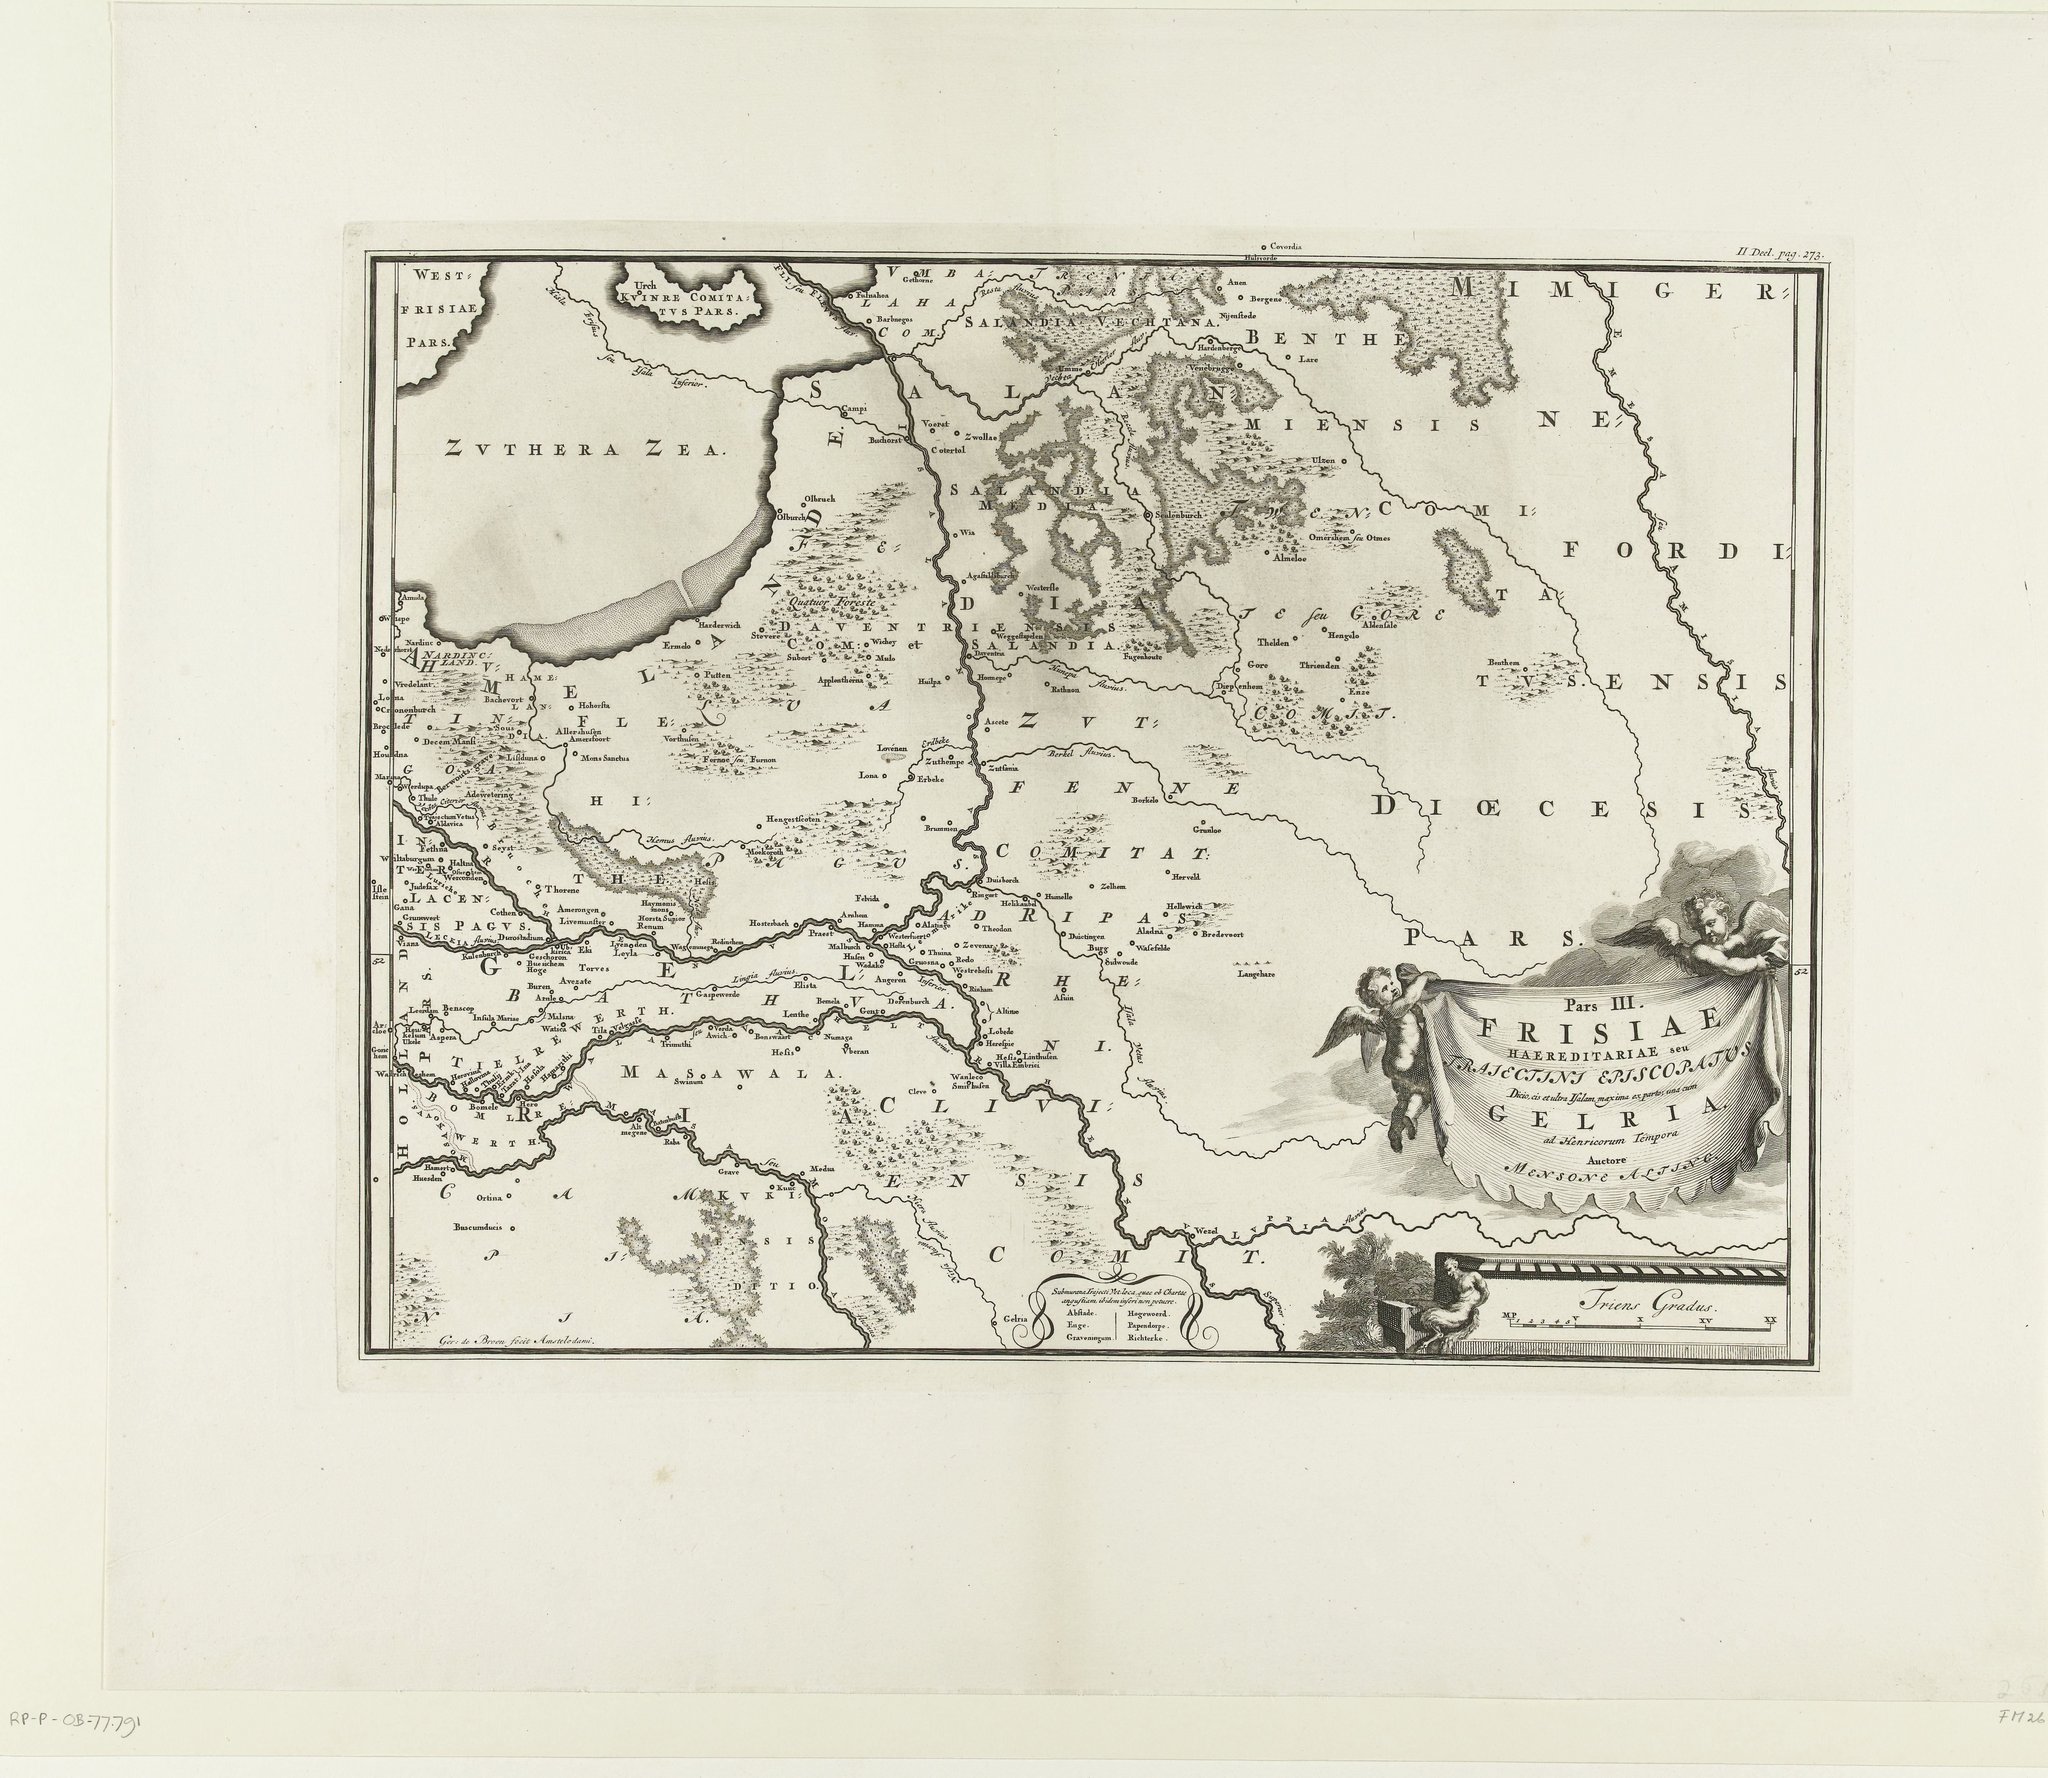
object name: history print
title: Historische kaart van Nederland met de gebieden van de Bataven en Friezen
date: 1695-1700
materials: paper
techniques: etching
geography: netherlands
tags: maps of separate countries or regions, netherlands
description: Kaart van het gebied rond Utrecht. Maakt deel uit van 16 kaarten van het land van de Bataven en de Friezen eerst vervaardigd voor en opgenomen in M. Alting, Descriptio ant. agri Batavi et Frisii, s. notitia Germ. infer., 2 delen, 1697-1700. Hergebruikt in F. Halma, Tooneel der Vereenigde Nederlanden en onderhorige landschappen, geopent in een algemeen historisch, genealogisch, geographisch en staatkundig woordenboek, 2 delen, 1725. Volgens opschrift geplaatst in: Deel II, pag. 273.